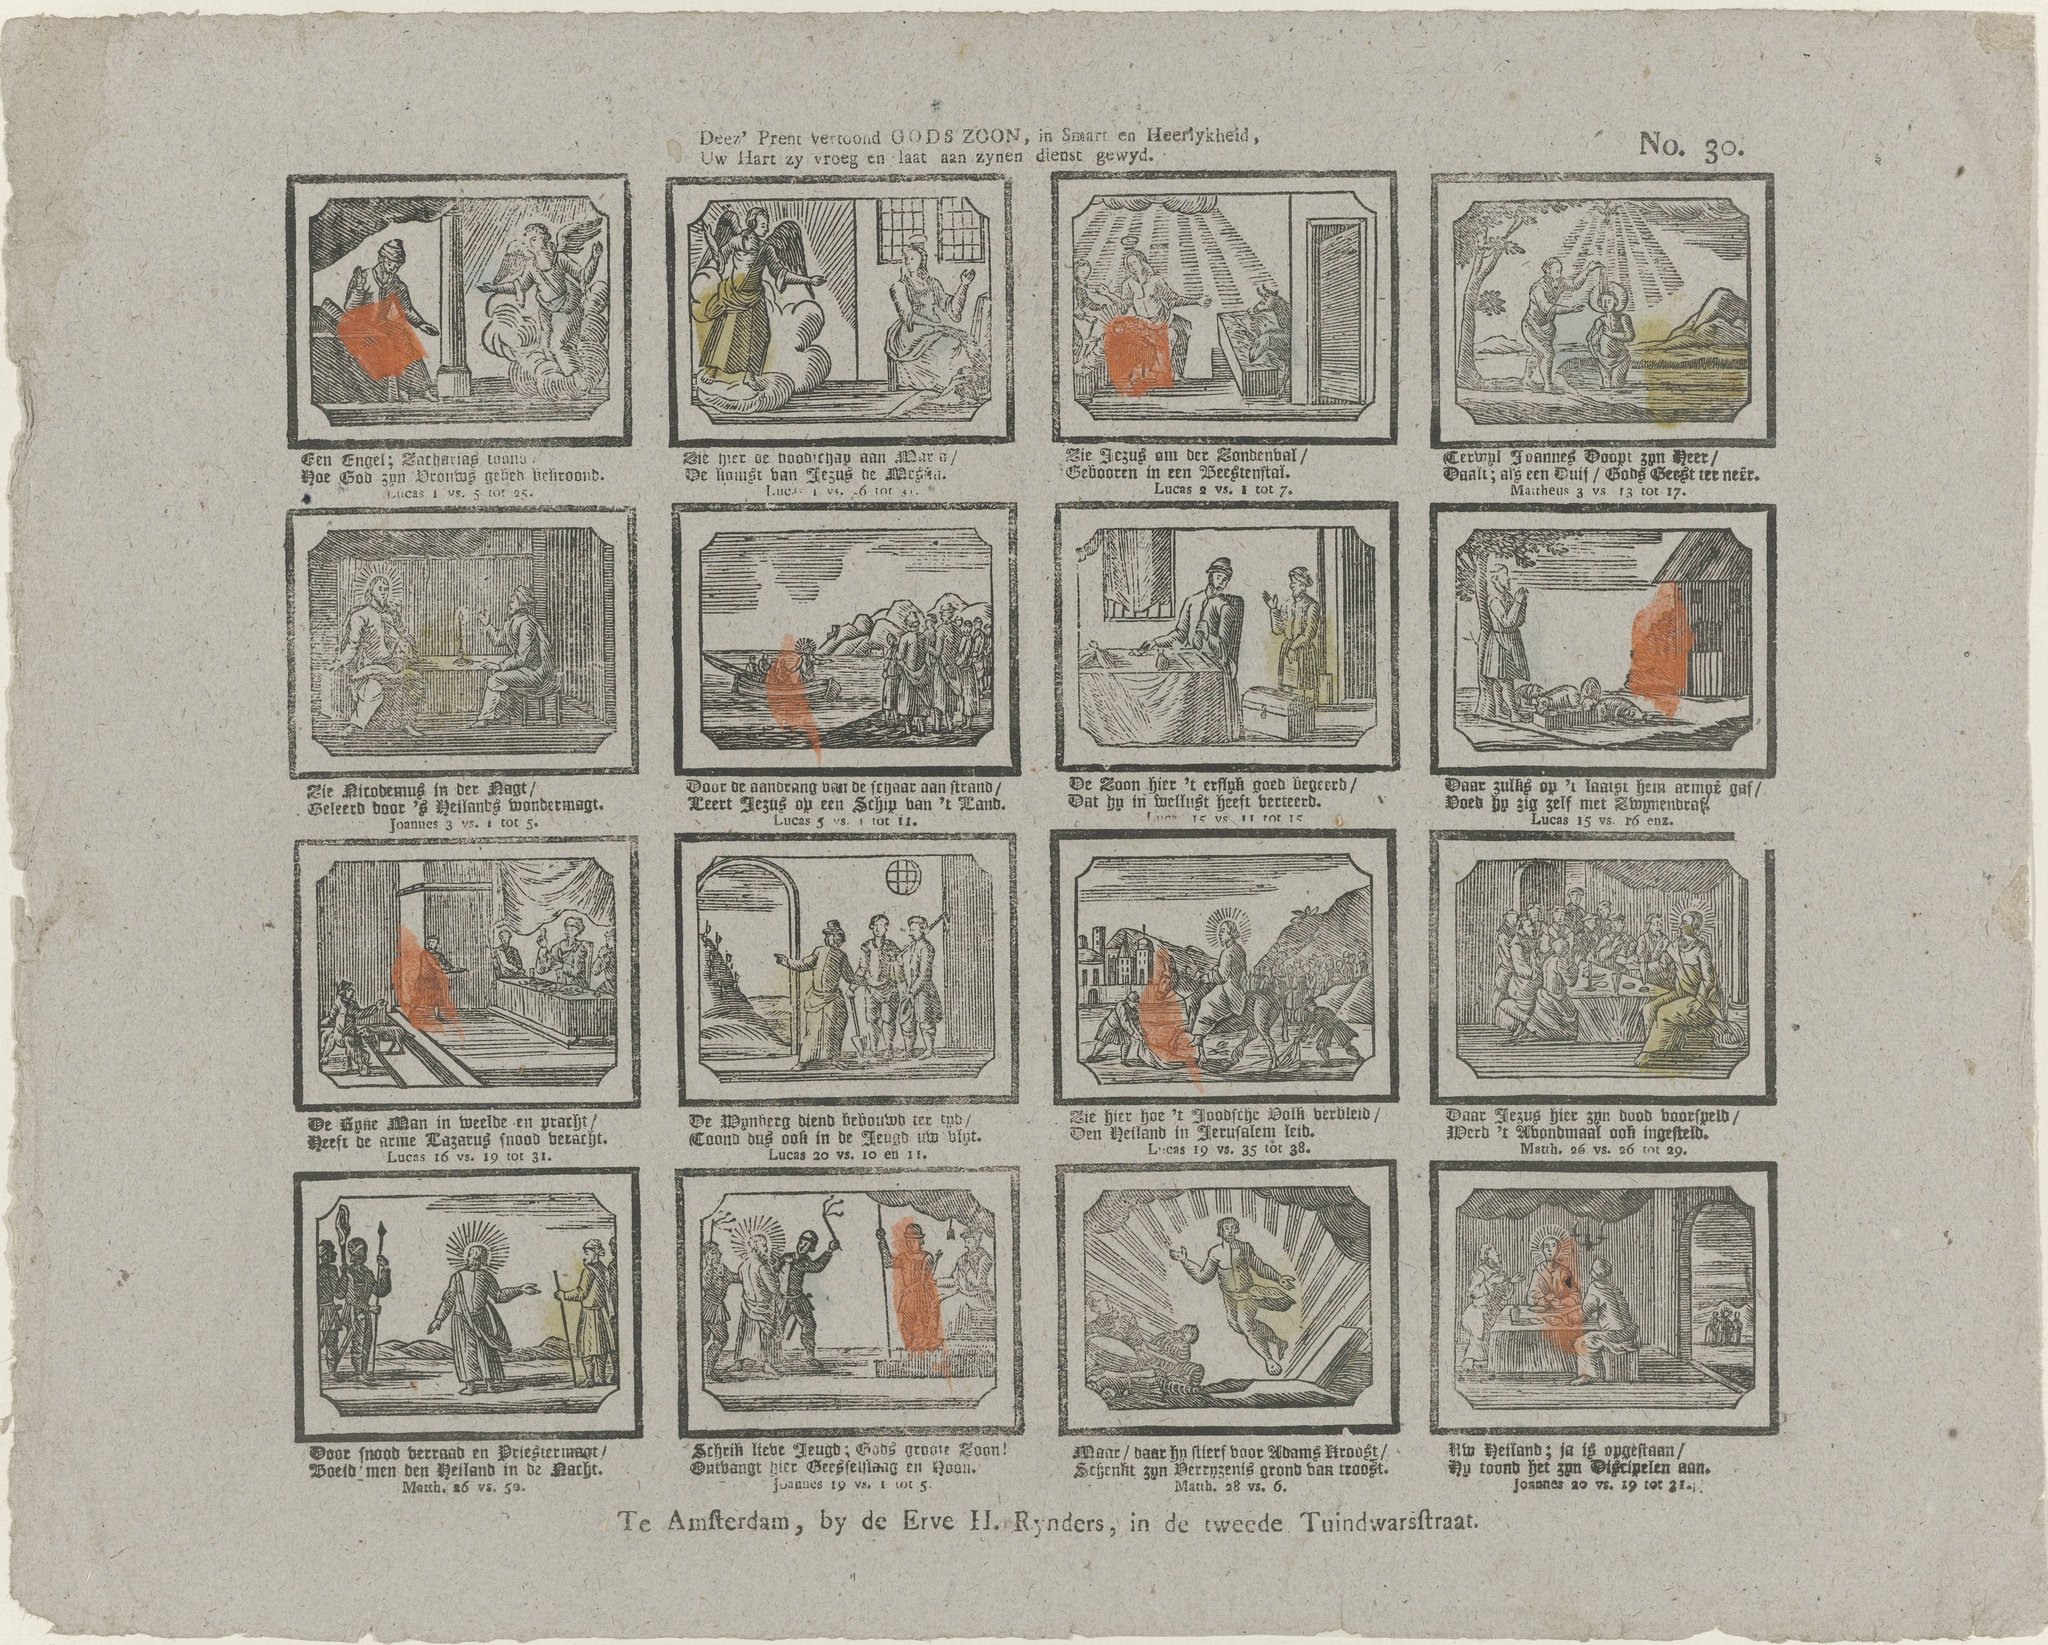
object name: print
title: Deez' prent vertoond Gods zoon, in smart en heerlykheid, / Uw hart zy vroeg en laat aan zynen dienst gewyd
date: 1831-1854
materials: paper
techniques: colour, letterpress printing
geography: amsterdam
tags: new testament, series of scenes from the life of christ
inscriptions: collector's mark: Lugt 2760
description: Blad met 16 voorstellingen van verhalen uit het Nieuwe Testament, zoals de doop in de Jordaan en de intocht in Jerusalem. Onder elke afbeelding een tweeregelig vers en een verwijzing naar de bijbehorende Bijbeltekst. Genummerd rechtsboven: No. 30.